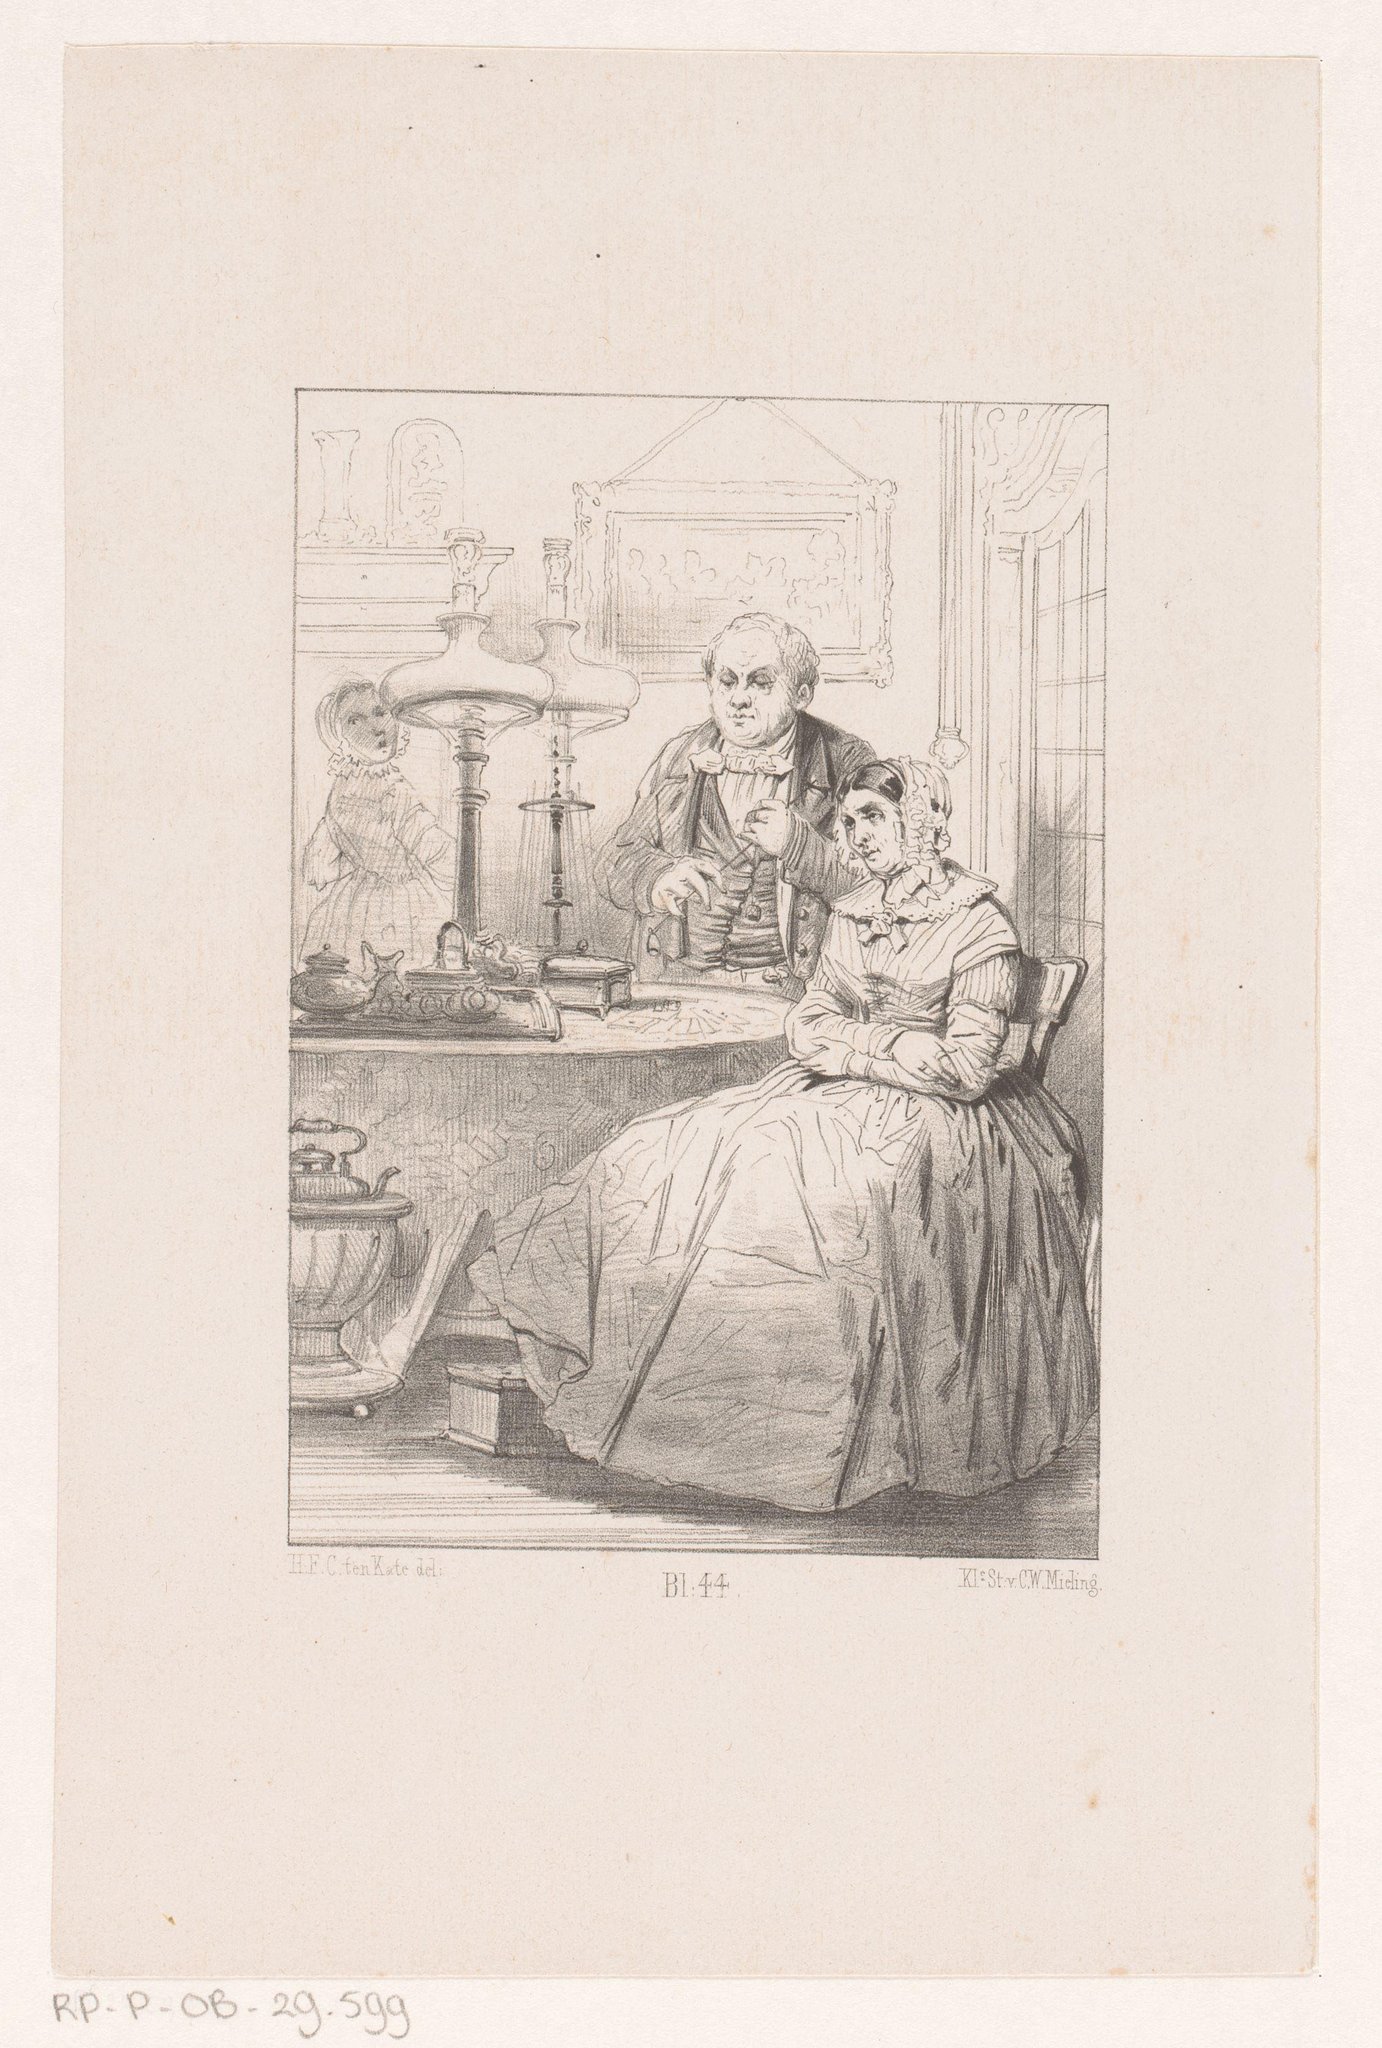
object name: print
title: Twee mensen aan tafel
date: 1847-1865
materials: paper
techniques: lithograph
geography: the hague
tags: conversation, dialogue; conversation piece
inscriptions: collector's mark: Lugt 2228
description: Een man staat naast zijn vrouw zittend aan een tafel waarop twee lampen staan. Midden onder genummerd Bl. 44.